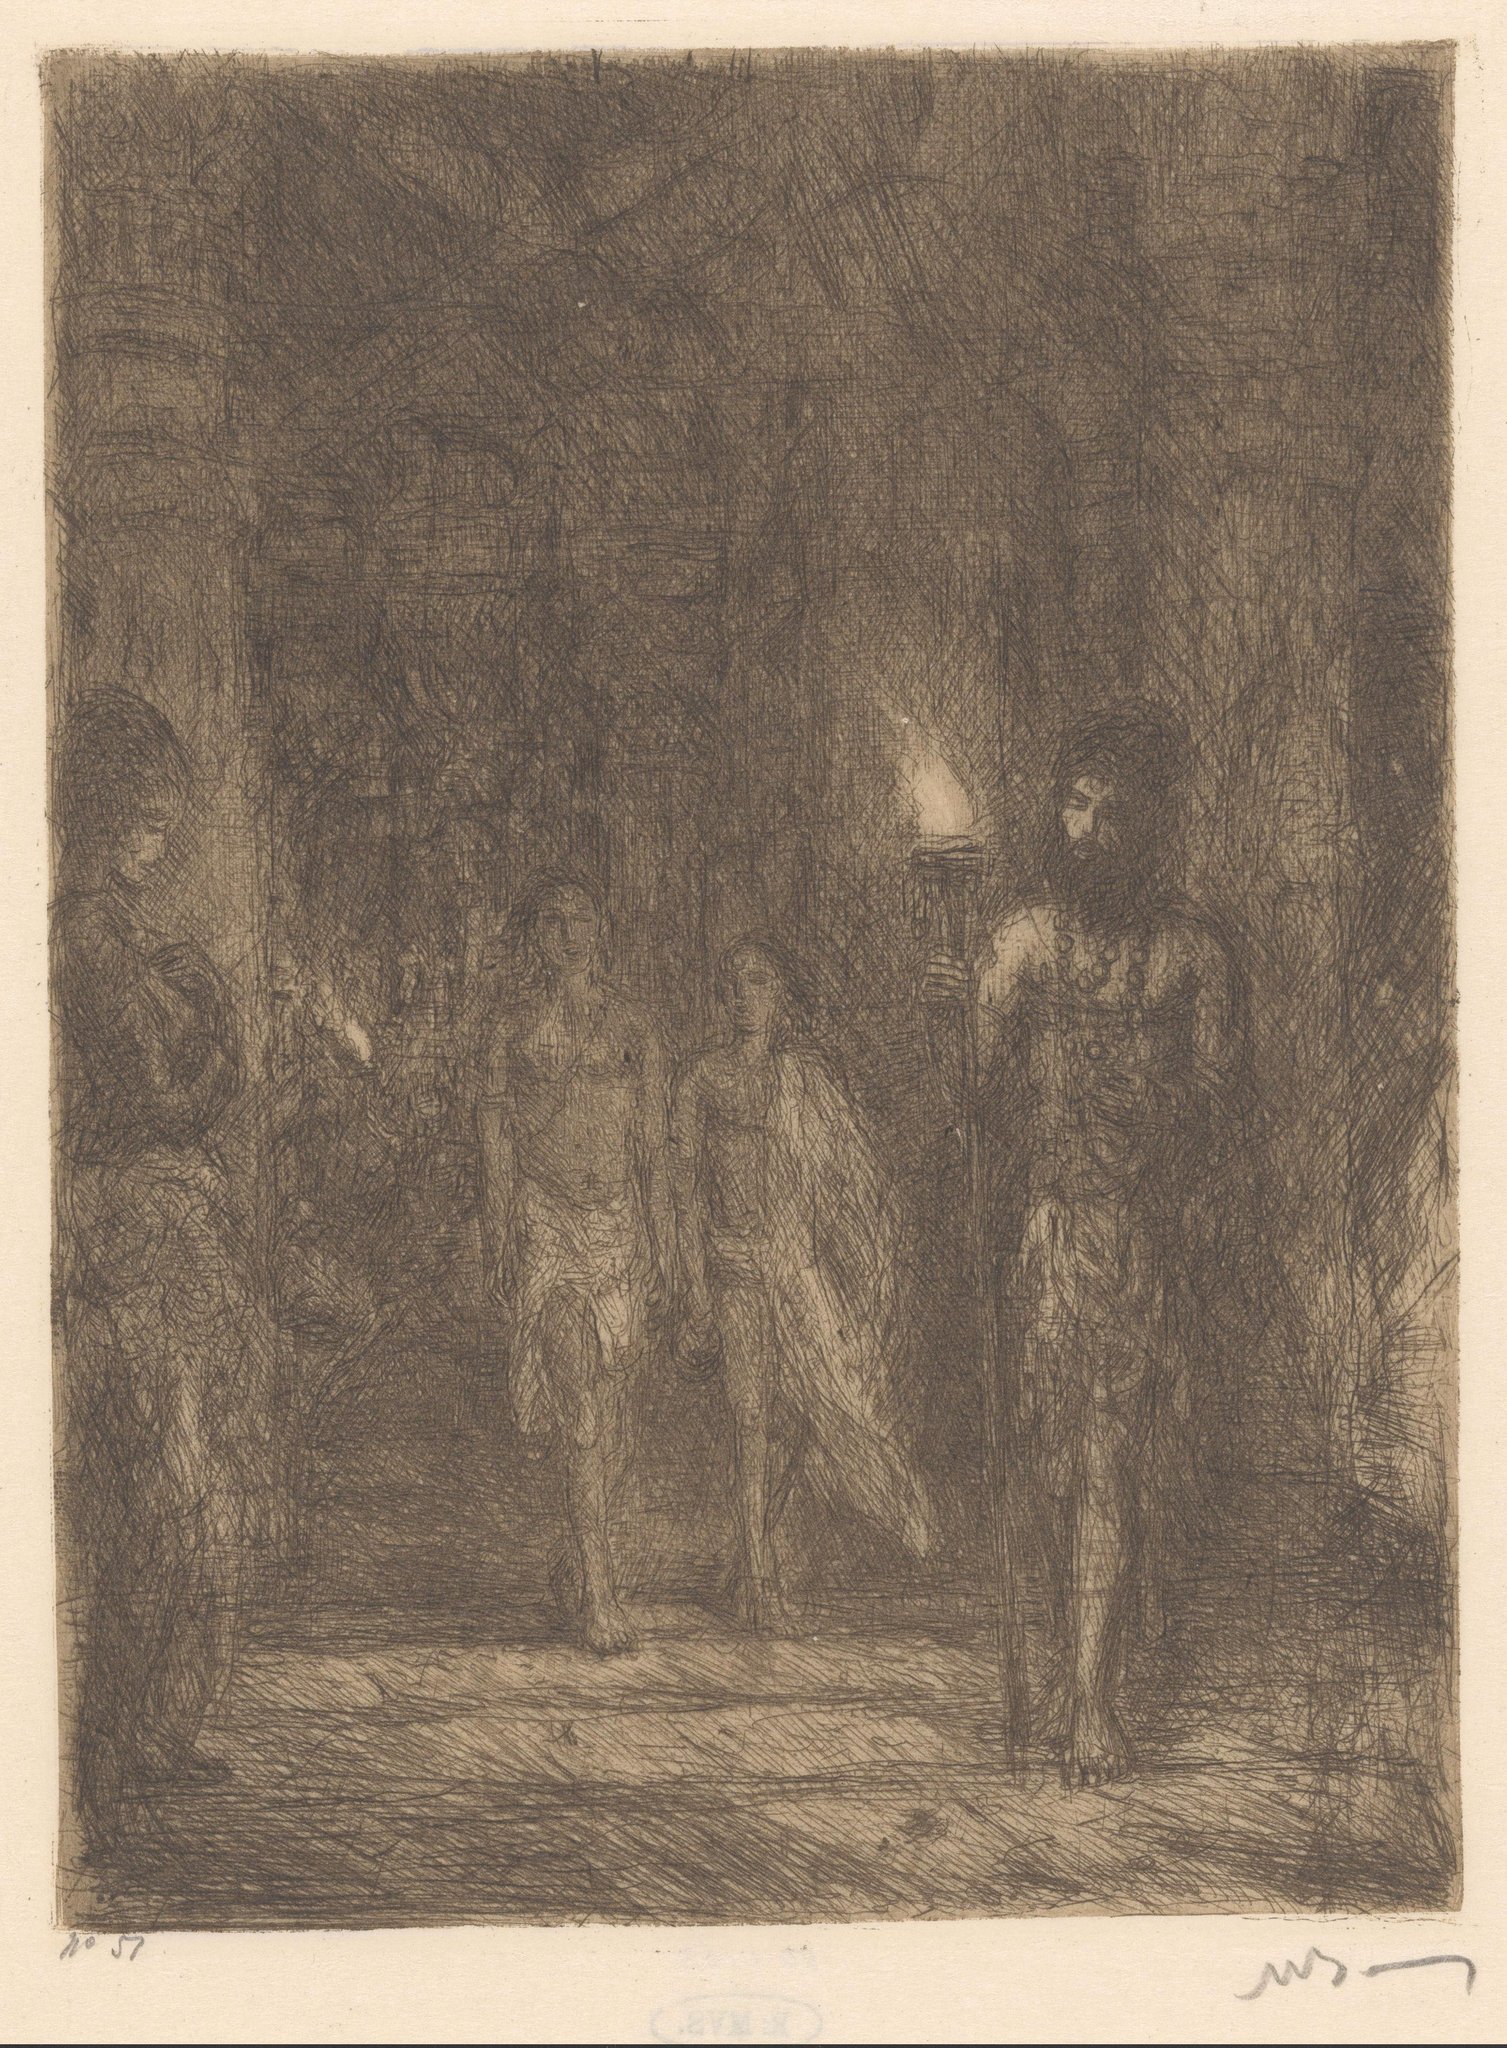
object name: print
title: Fakir in de Minakshitempel in Madurai in Brits-Indië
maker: marius bauer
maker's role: draughtsman, print maker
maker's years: 1867-1932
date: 1926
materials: paper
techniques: etching, intaglio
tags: temple, shrine ~ hinduism, buddhism, jainism, torch, asceticism ~ hinduism, buddhism, jainism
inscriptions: collector's mark: Lugt 2228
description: Een bebaarde man met een ketting loopt met een brandende fakkel door een gang met aan weerszijden een zuilenrij. Achter hem lopen nog twee figuren. Links op de voorgrond staat een figuur bij een zuil.